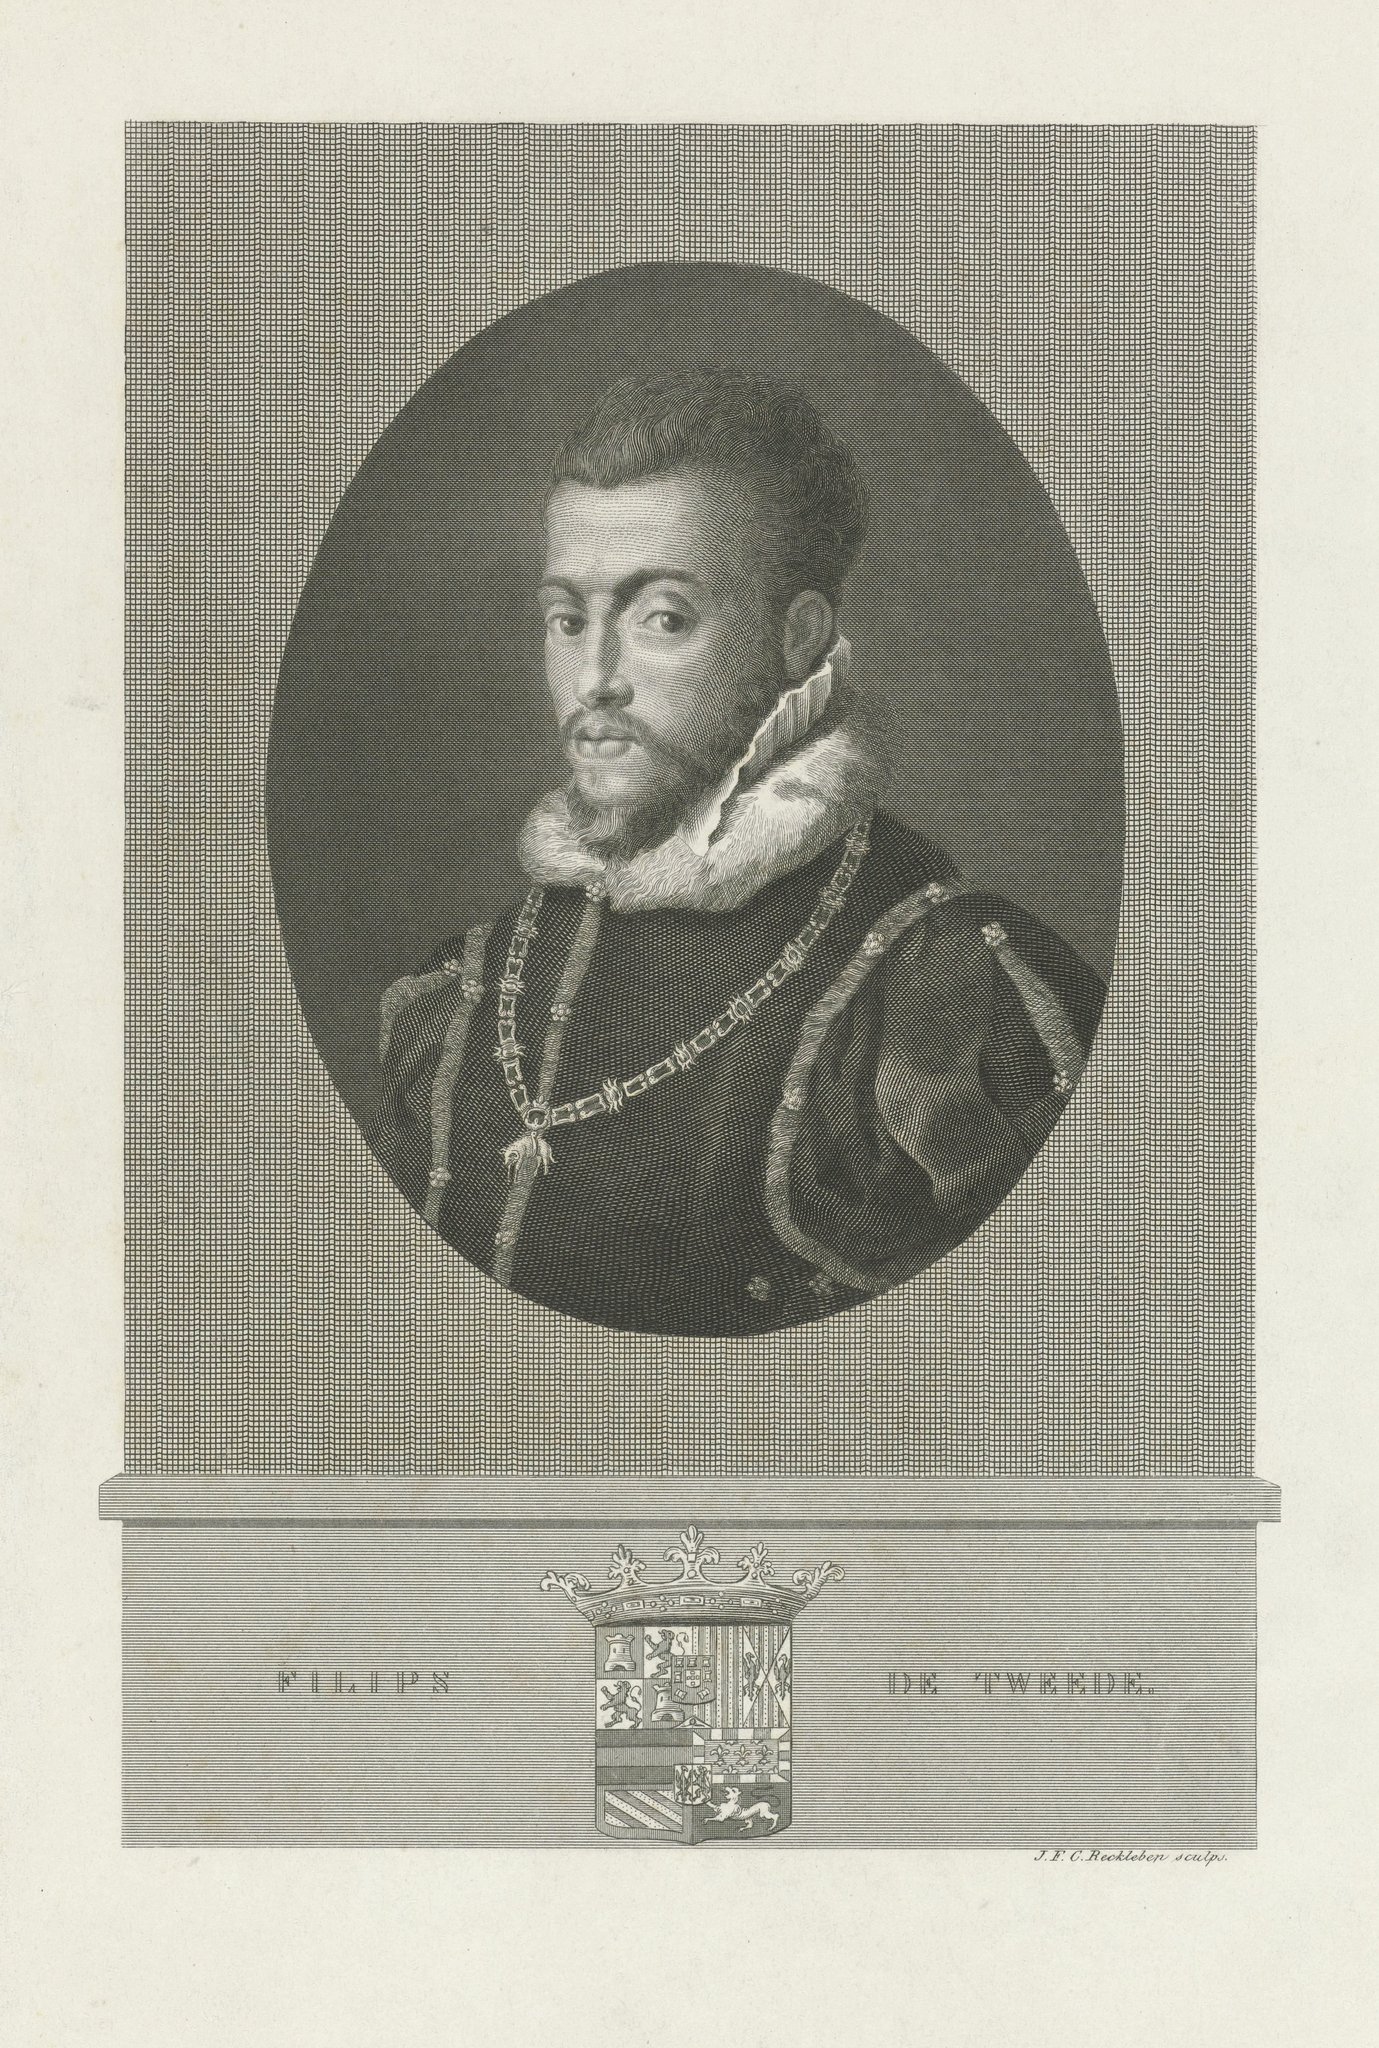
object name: print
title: Portret van Filips II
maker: jan frederik christiaan reckleben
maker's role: print maker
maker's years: 1819-1879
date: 1849-1851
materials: paper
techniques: engraving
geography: amsterdam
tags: philip ii of spain, knighthood order of the golden fleece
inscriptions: collector's mark: Lugt 2228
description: Illustratie in: Arend, Johannes Pieter. Algemeene geschiedenis des vaderlands van de vroegste tijden tot op heden. 5 delen, Amsterdam: Schleijer, J.F. 1840-1884, dl. 2.4, p. 52.